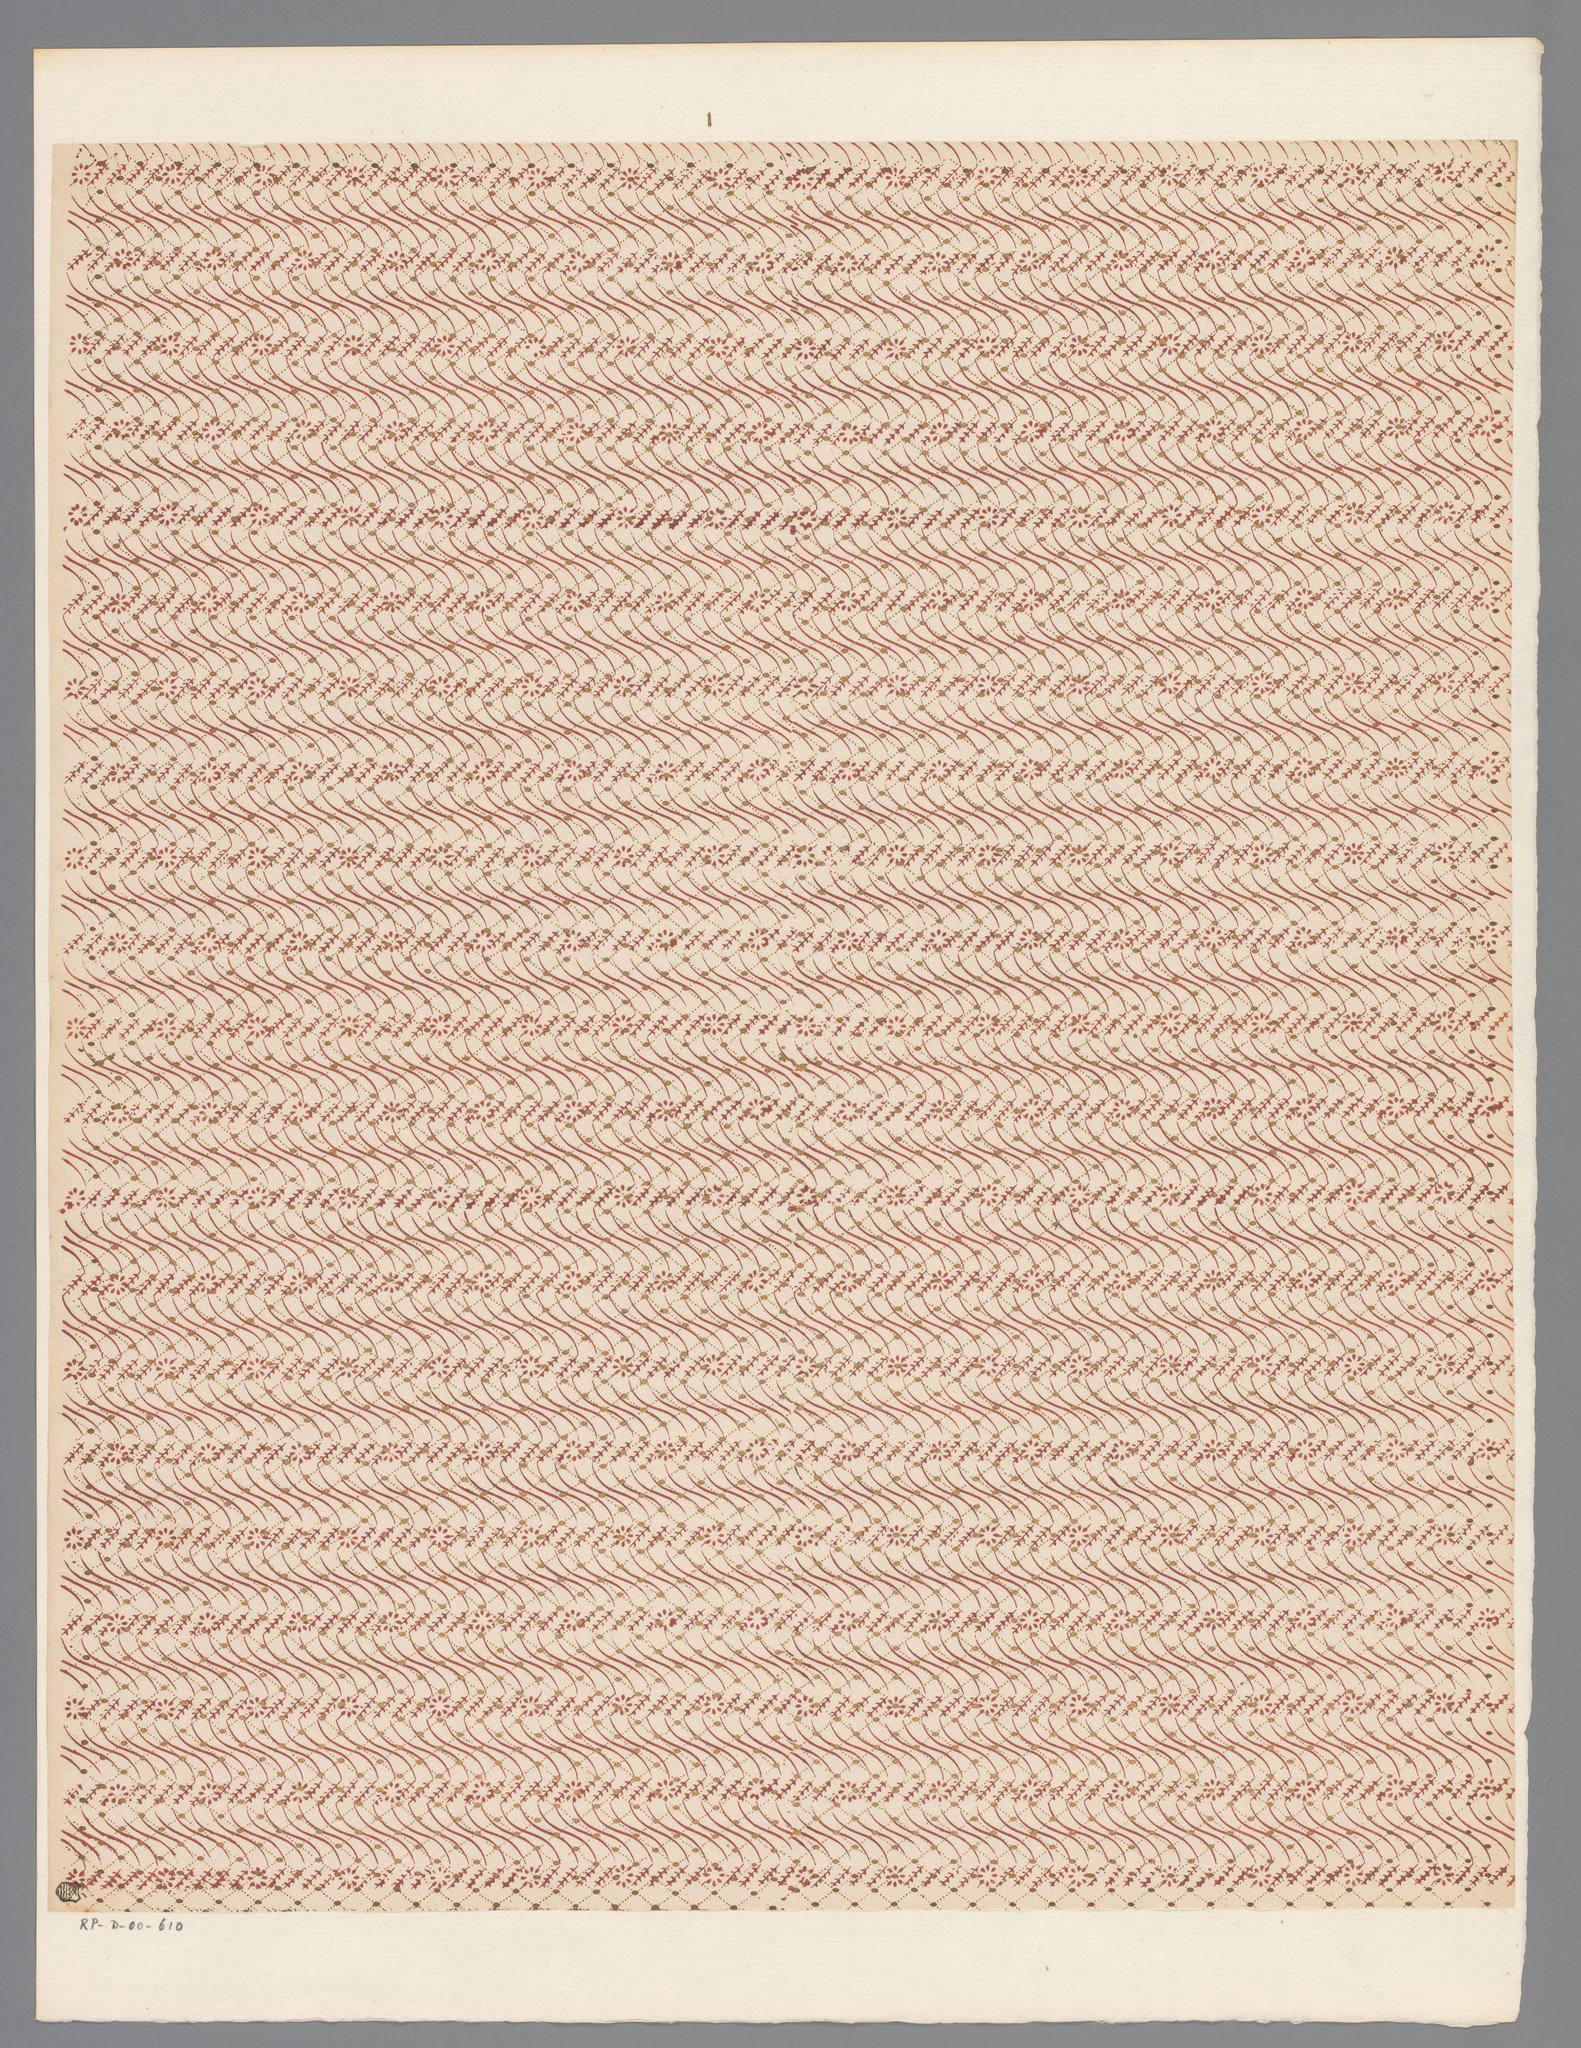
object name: printed paper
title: Blad met banenpatroon van bloemmotief en golvend motief met ruitenpatroon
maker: Anonymous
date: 1800-1900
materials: paint, paper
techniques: printing block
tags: ornament ~ round and curved forms, ornament derived from plant forms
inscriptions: collector's mark: Lugt 2760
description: Blad met verticaal banenpatroon van een bloemmotief en een golvend motief onder een ruitenpatroon.